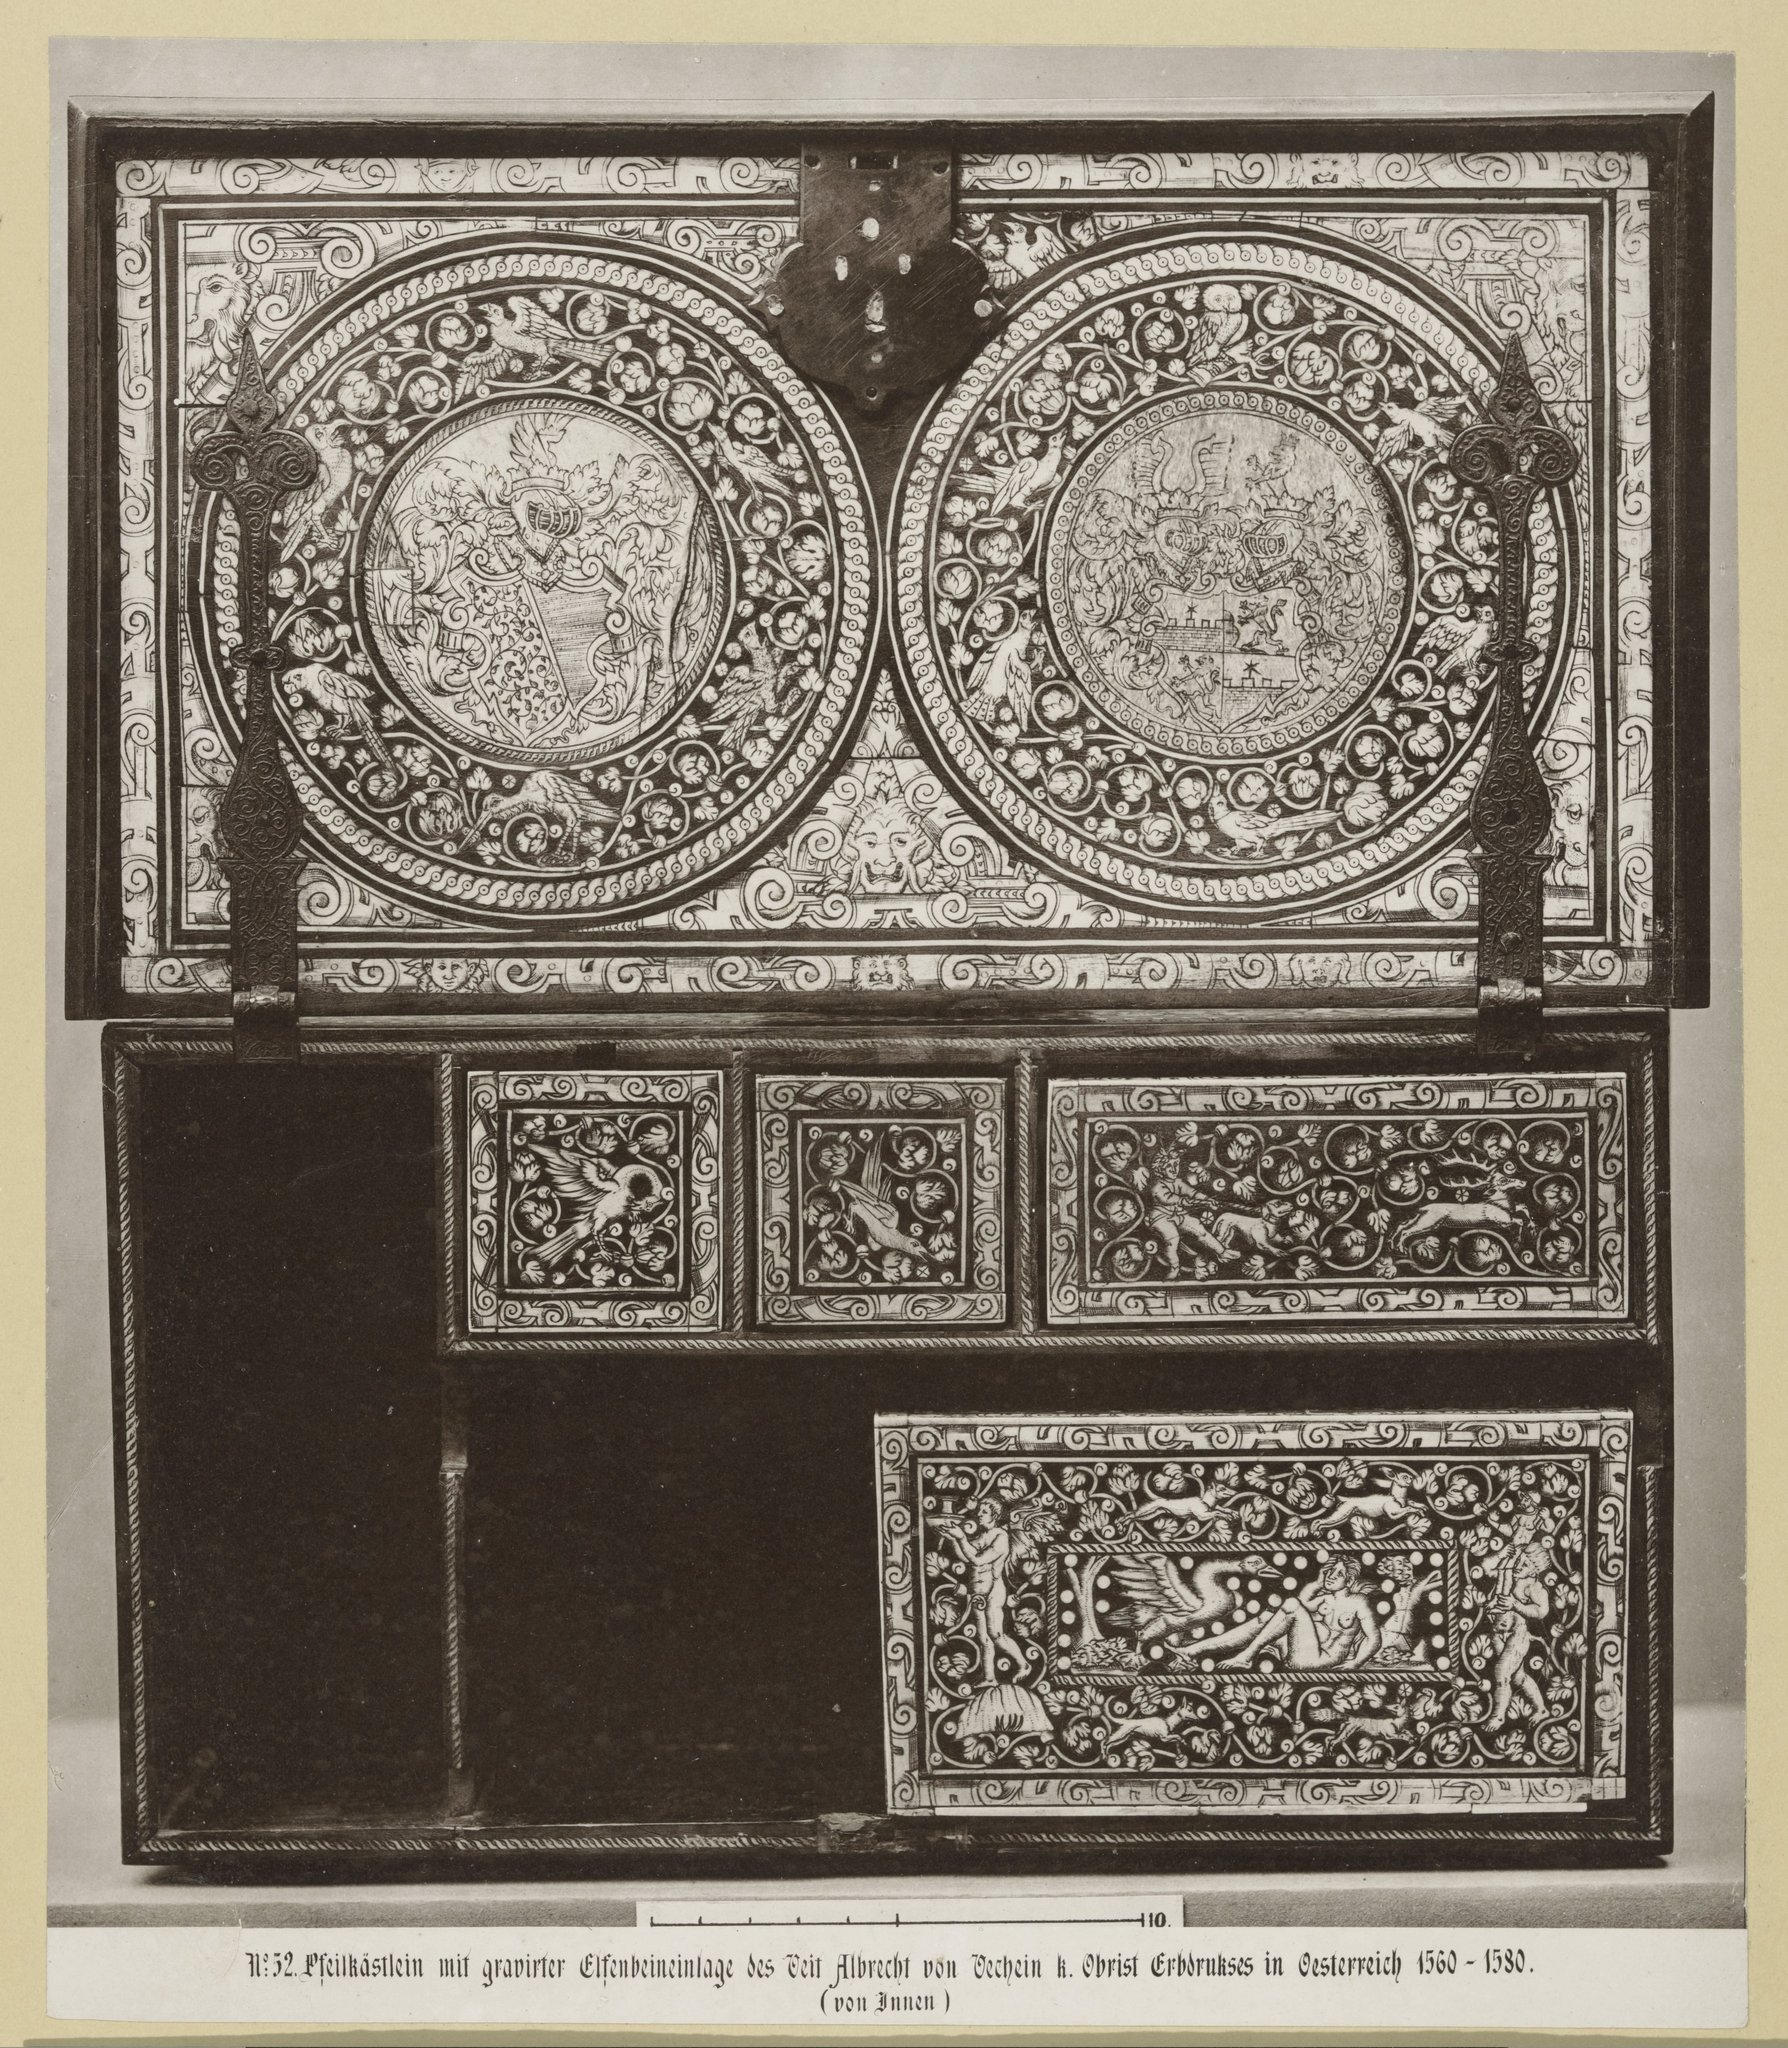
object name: photomechanical print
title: Pfeilkästlein mit gravirter Elfenbeineinlage des Veit Albrecht von Vechein k. Obrist Erbdrukses in Oesterreich 1560-1580. (von Innen)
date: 1869-1887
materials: cardboard, paper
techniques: photograph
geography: munich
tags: work of applied art, chest, coffer, germany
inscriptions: number: ‘No. 52.’